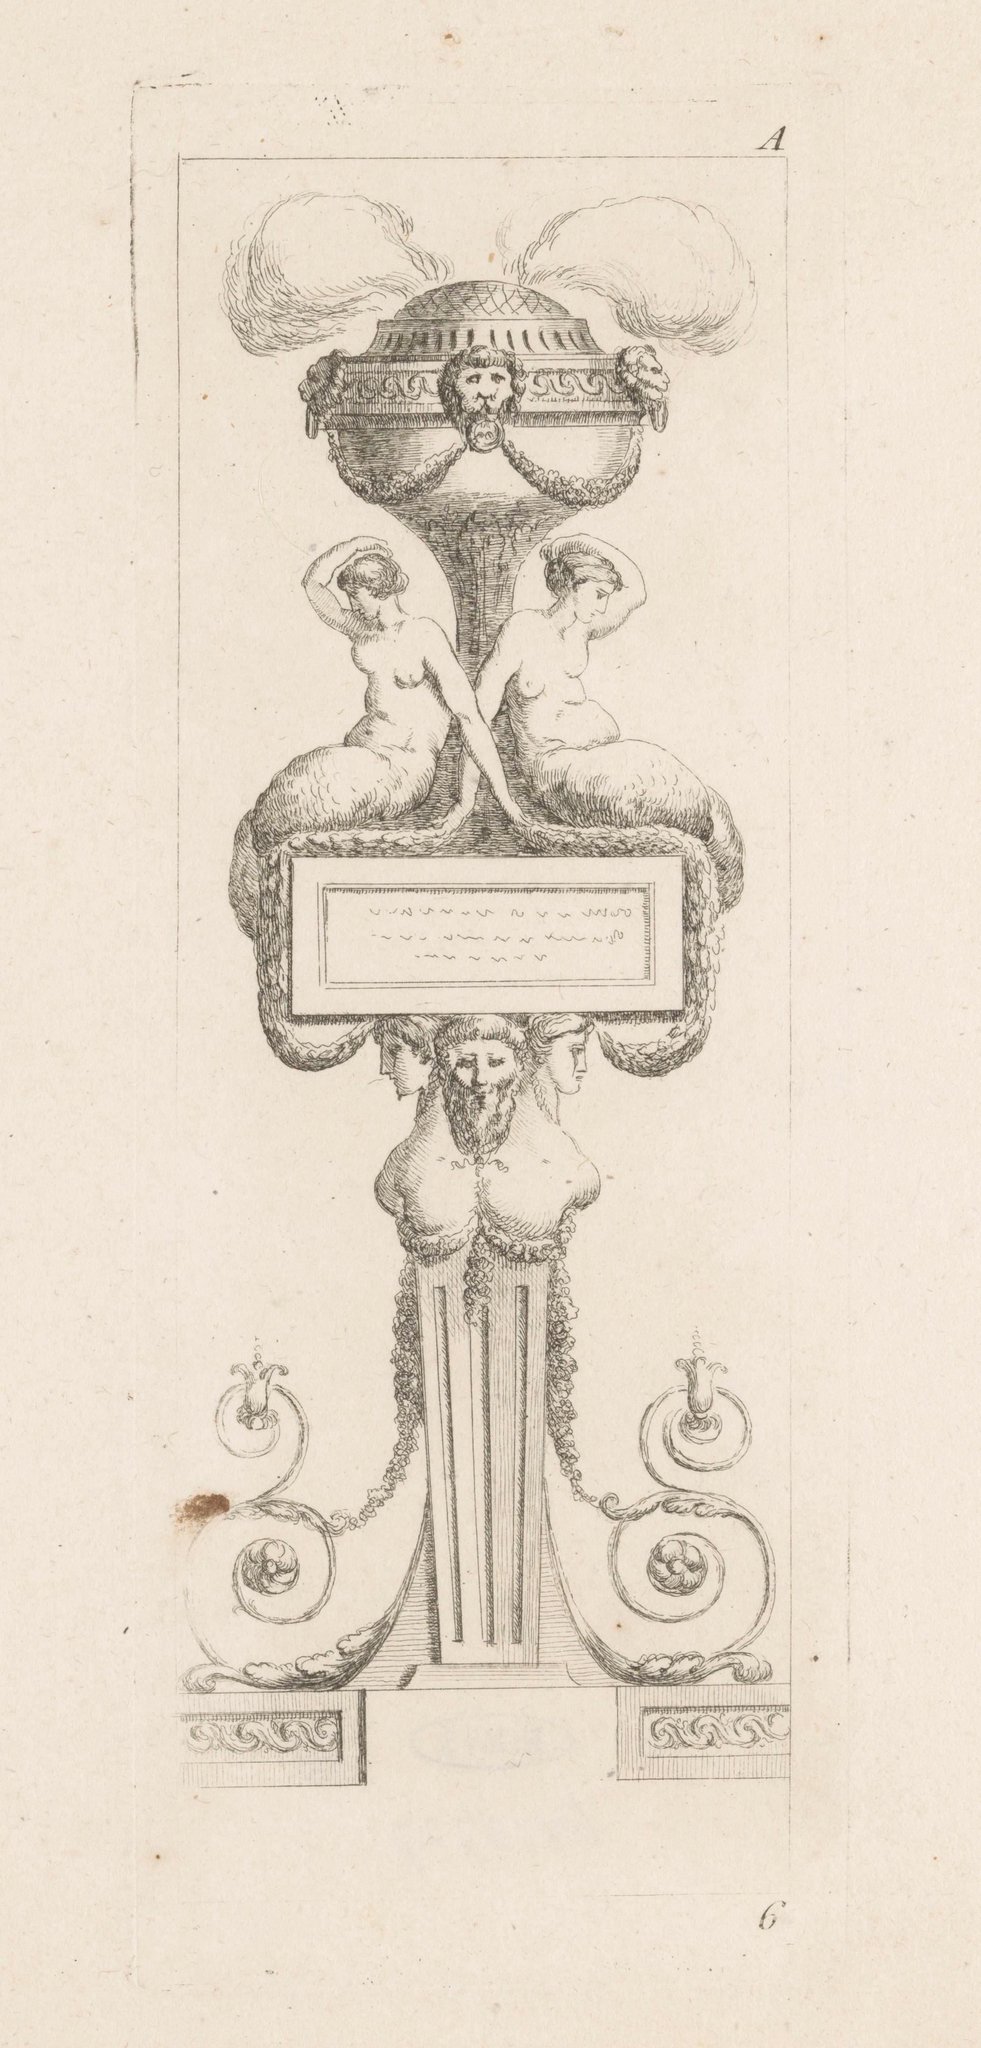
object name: print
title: A Premier Cahier D'Arabesques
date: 1752-1782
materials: paper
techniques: etching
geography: paris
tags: merman - aa - mermaid, siren, ornament ~ arabesque, pedestal of a piece of sculpture (perhaps in the form of a herm), incense-burner ~ scents, perfumes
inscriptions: collector's mark: Lugt 2228, collector's mark: Lugt 2760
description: Twee meerminnen zitten op een tablet aan weerszijden van een rookvat, daaronder een voetstuk met drie hoofden en arabesken.